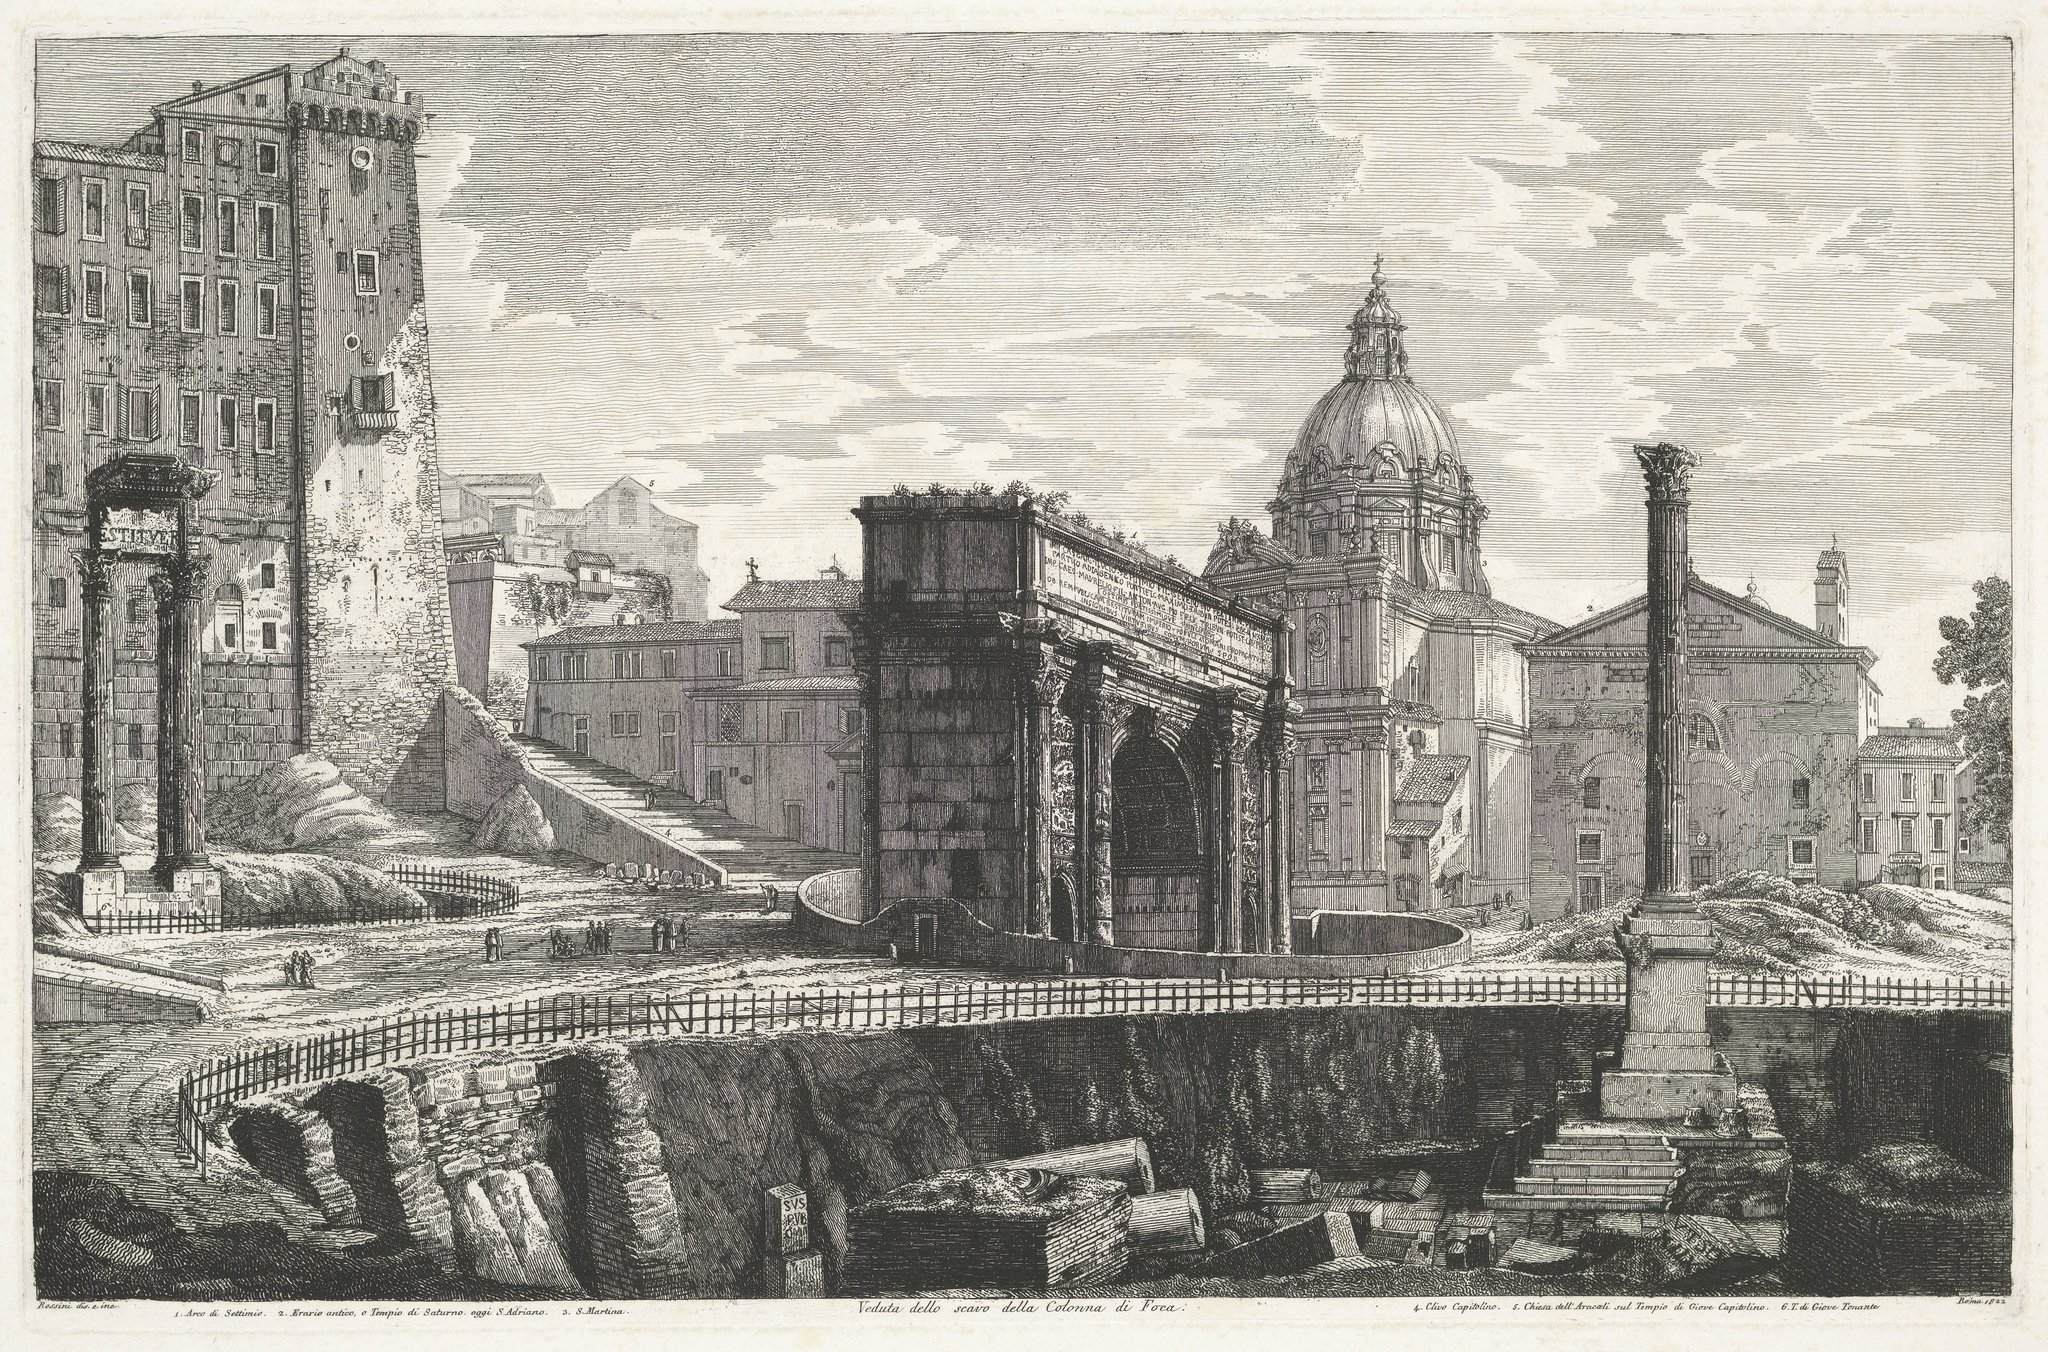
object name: print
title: De Zuil van Phocas op het Forum Romanum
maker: luigi rossini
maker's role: print maker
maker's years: 1790-1857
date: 1822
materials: paper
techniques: etching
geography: rome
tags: triumphal arch, landscape with ruins, rome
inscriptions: collector's mark: Lugt 2228, collector's mark: Lugt 2760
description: Gezicht op het Forum Romanum te Rome met op de voorgrond de Zuil van Phocas. Op de achtergrond de Boog van Septimius Severus en de Chiesa dei Santi Luca e Martina.